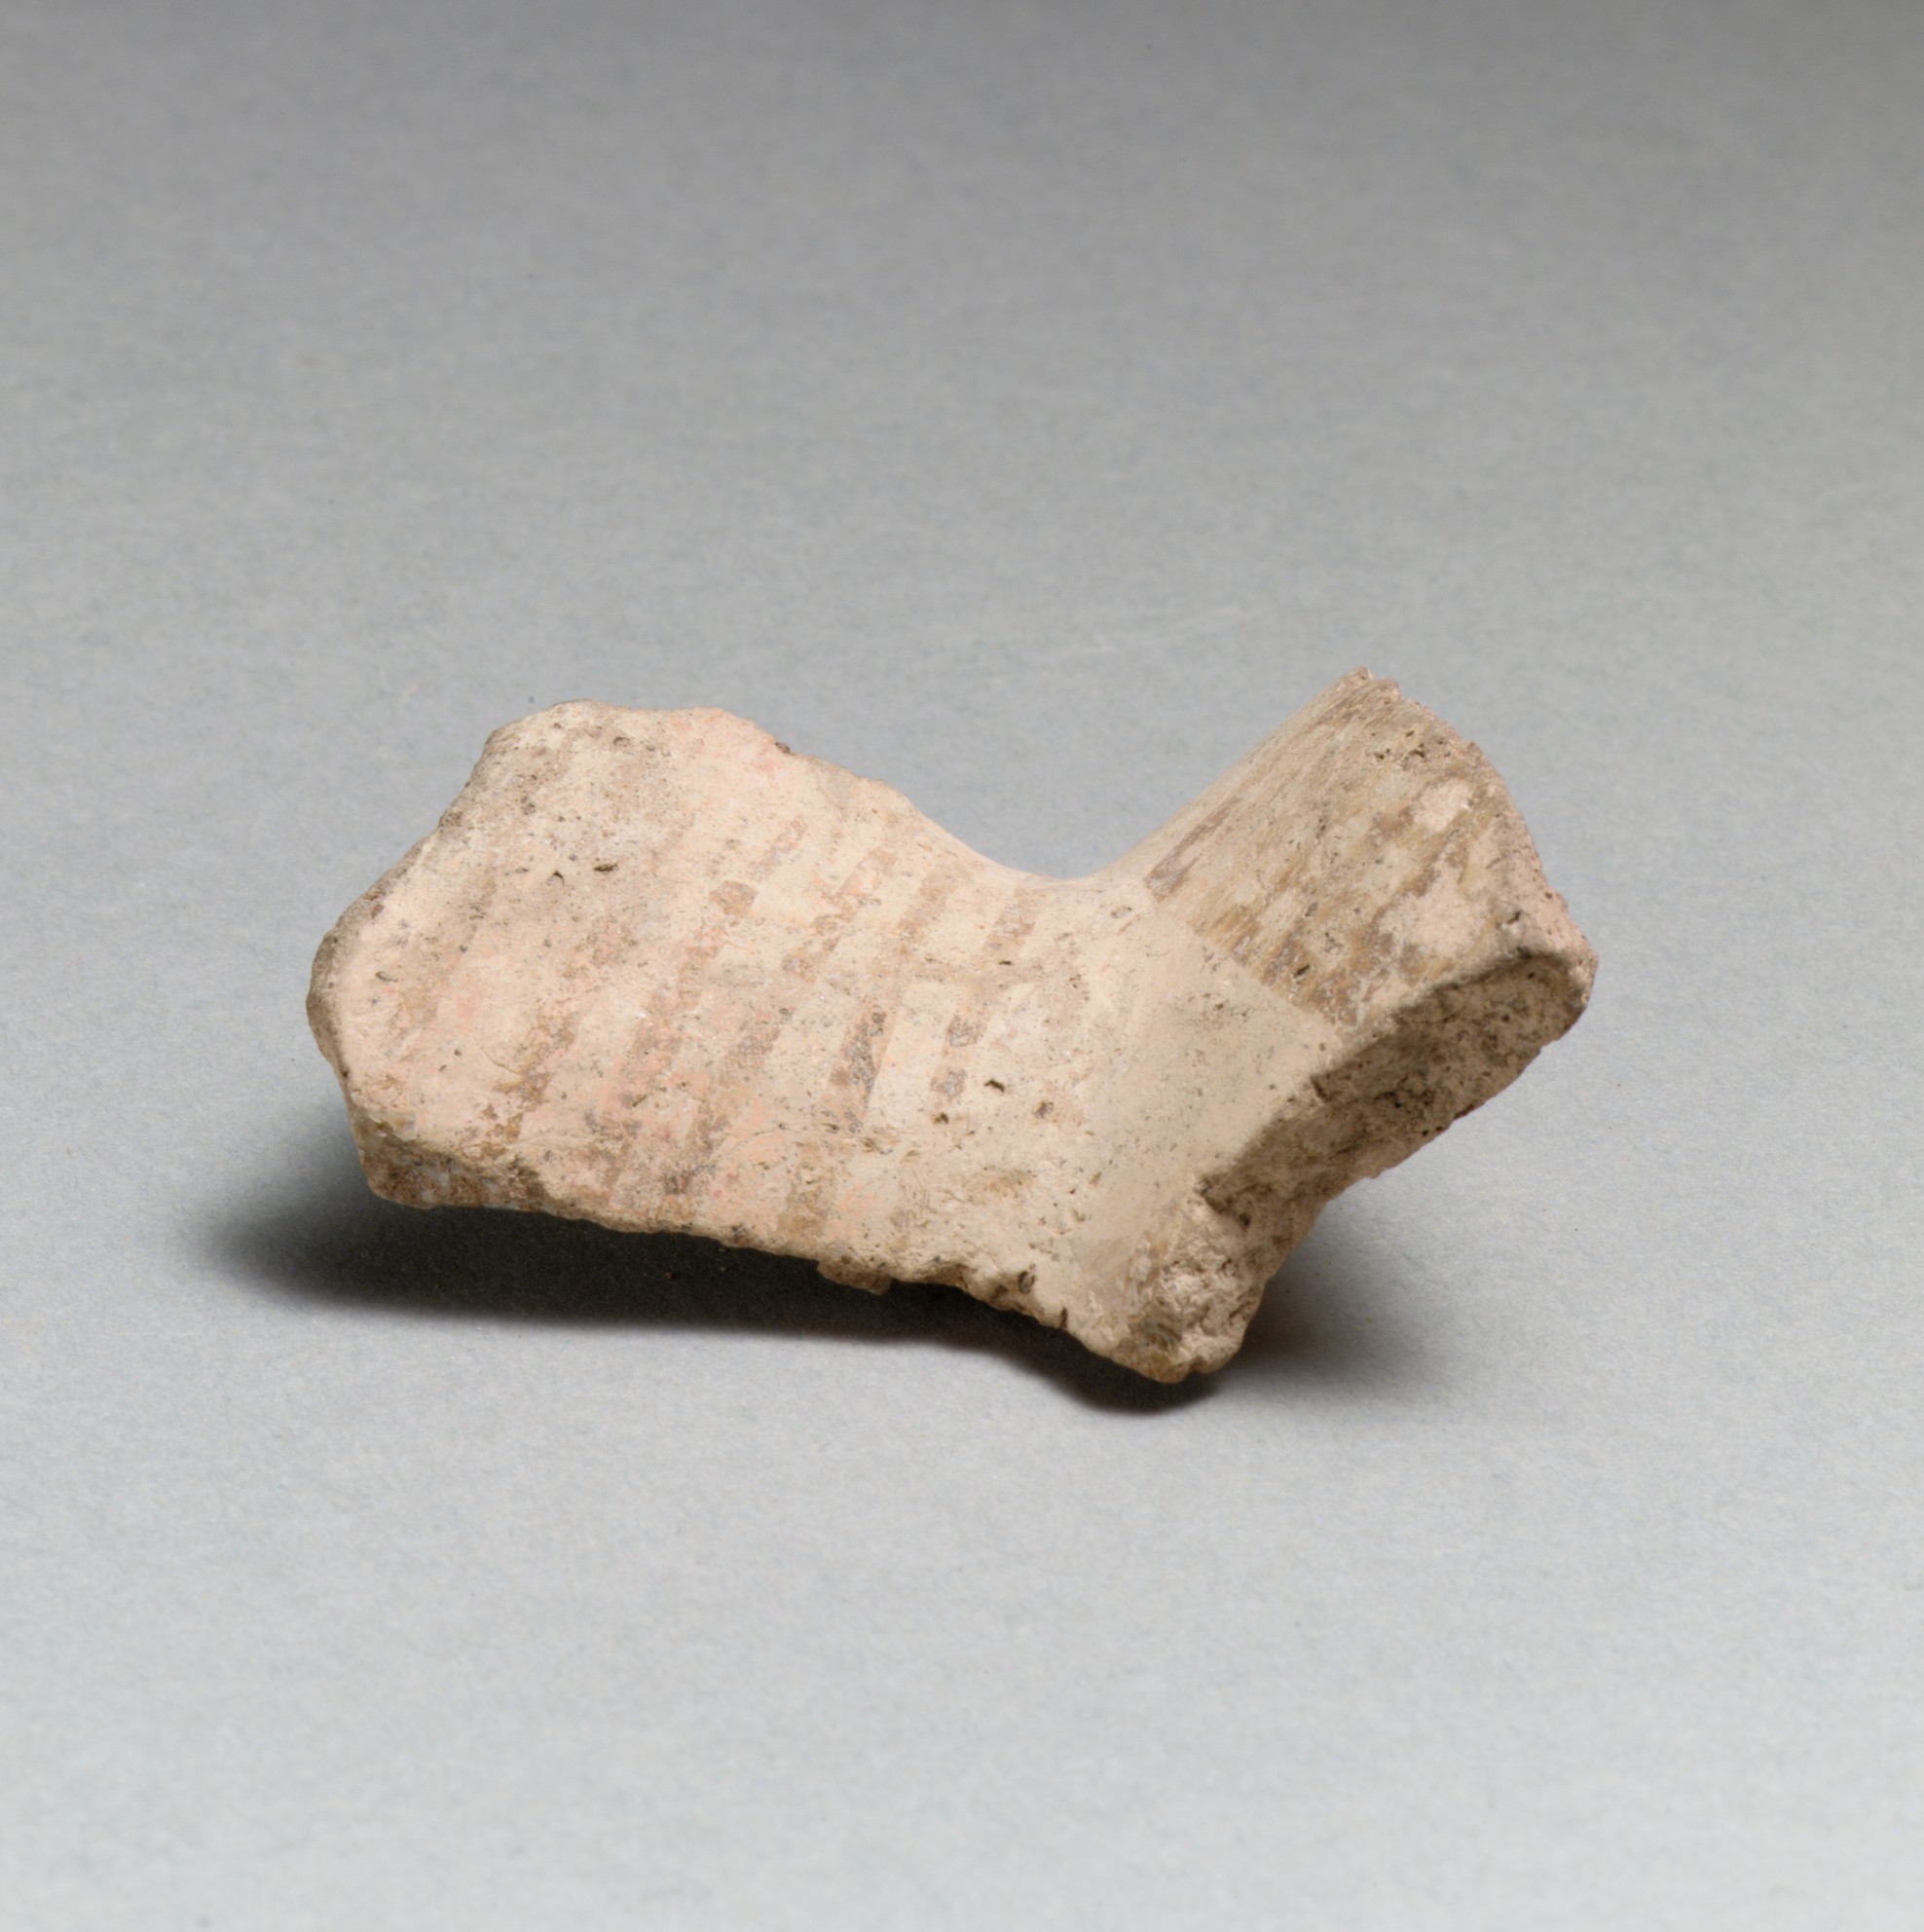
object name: vase fragment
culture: minoan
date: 2600-2000 BCE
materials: terracotta